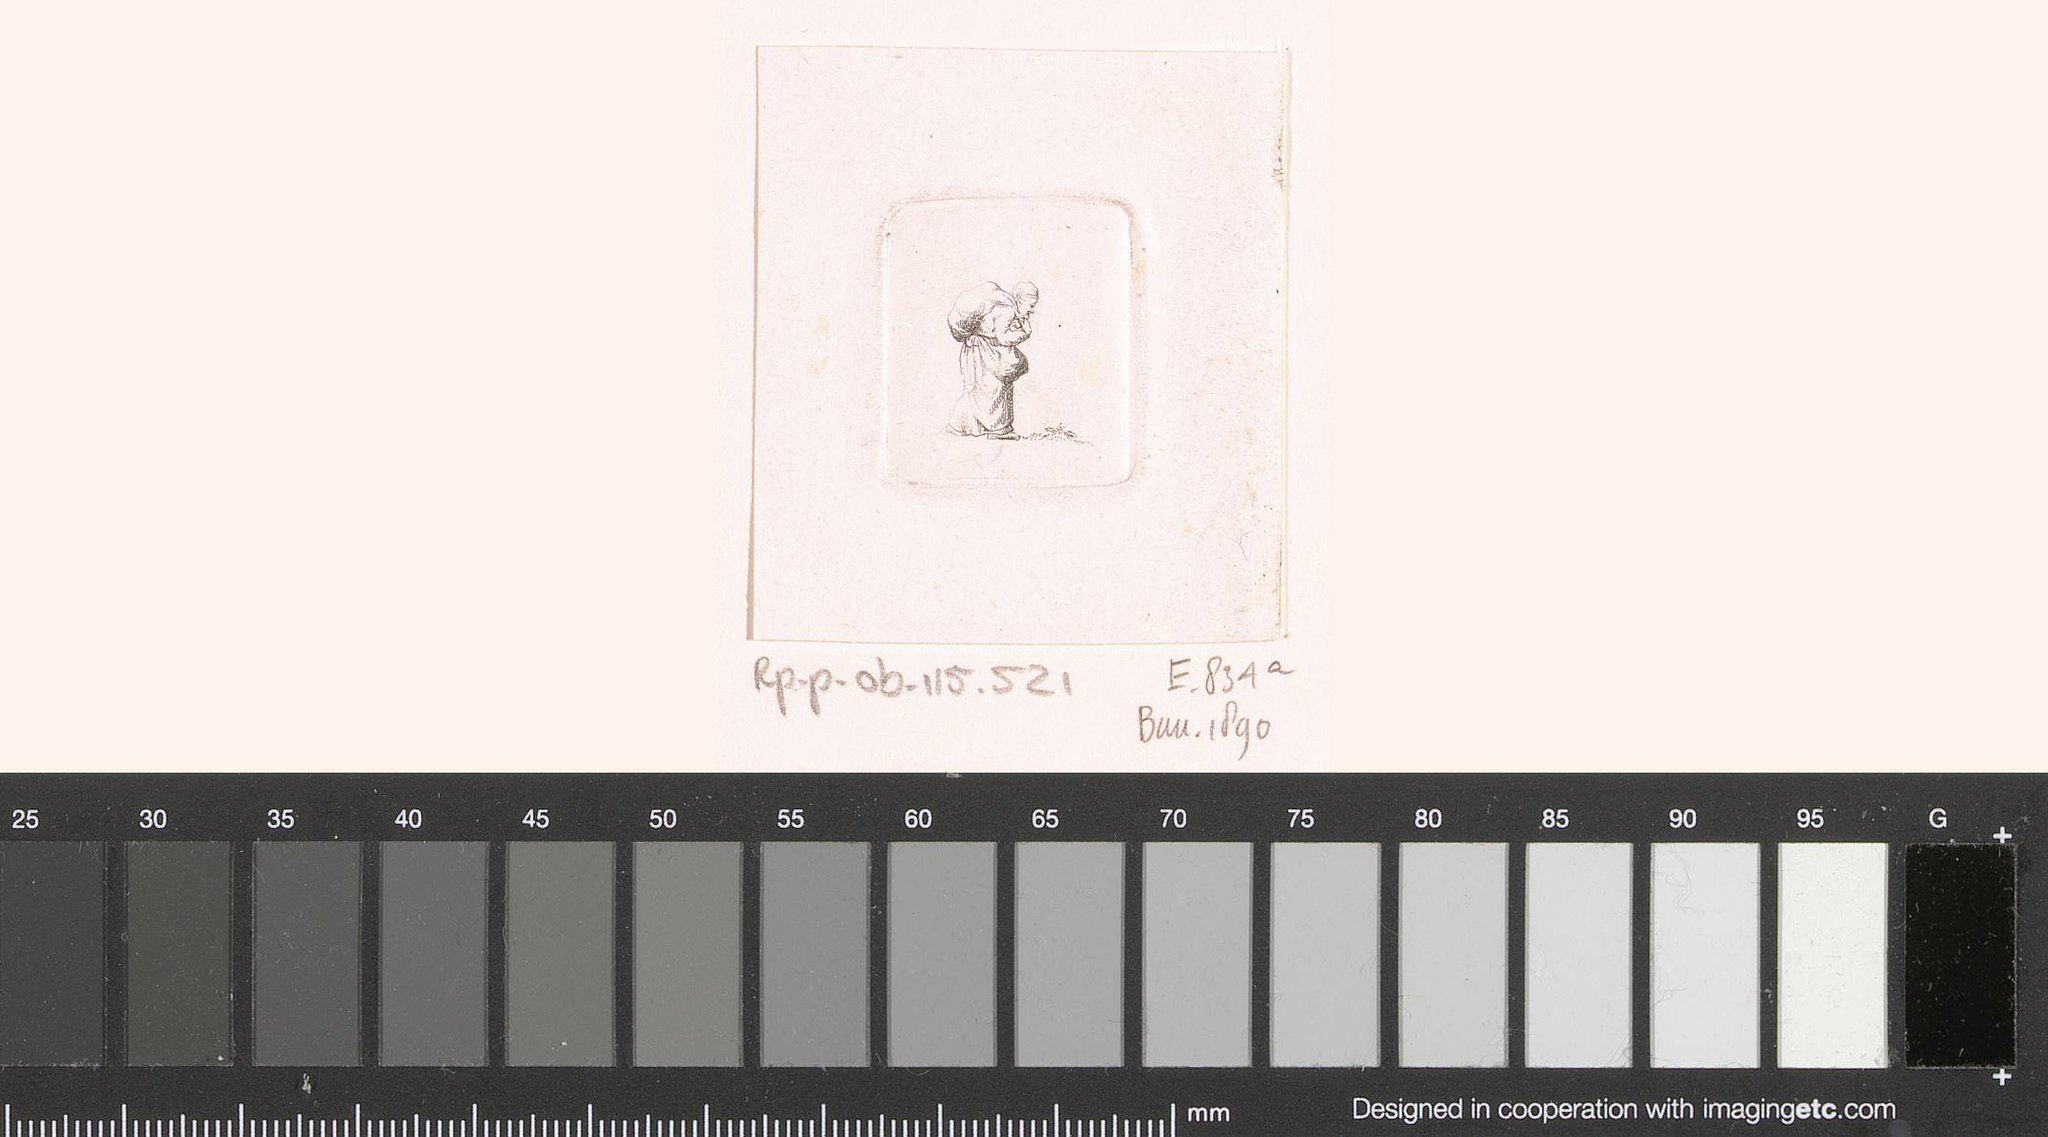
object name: print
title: Vluchtende vrouw met zak op haar rug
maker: daniel nikolaus chodowiecki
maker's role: draughtsman, print maker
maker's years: 1726-1801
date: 1796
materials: paper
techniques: etching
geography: berlin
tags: carrying something in basket, bag, rucksack, etc., political refugee, 'émigré'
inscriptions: collector's mark: Lugt 2228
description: Deze prent was, met nog vijf andere schetsmatige marge voorstellingen, onderdeel van de plaat waarop de prent 'Vluchtende mensen komen aan bij Hanau' was geëtst. Later is deze plaat versneden.